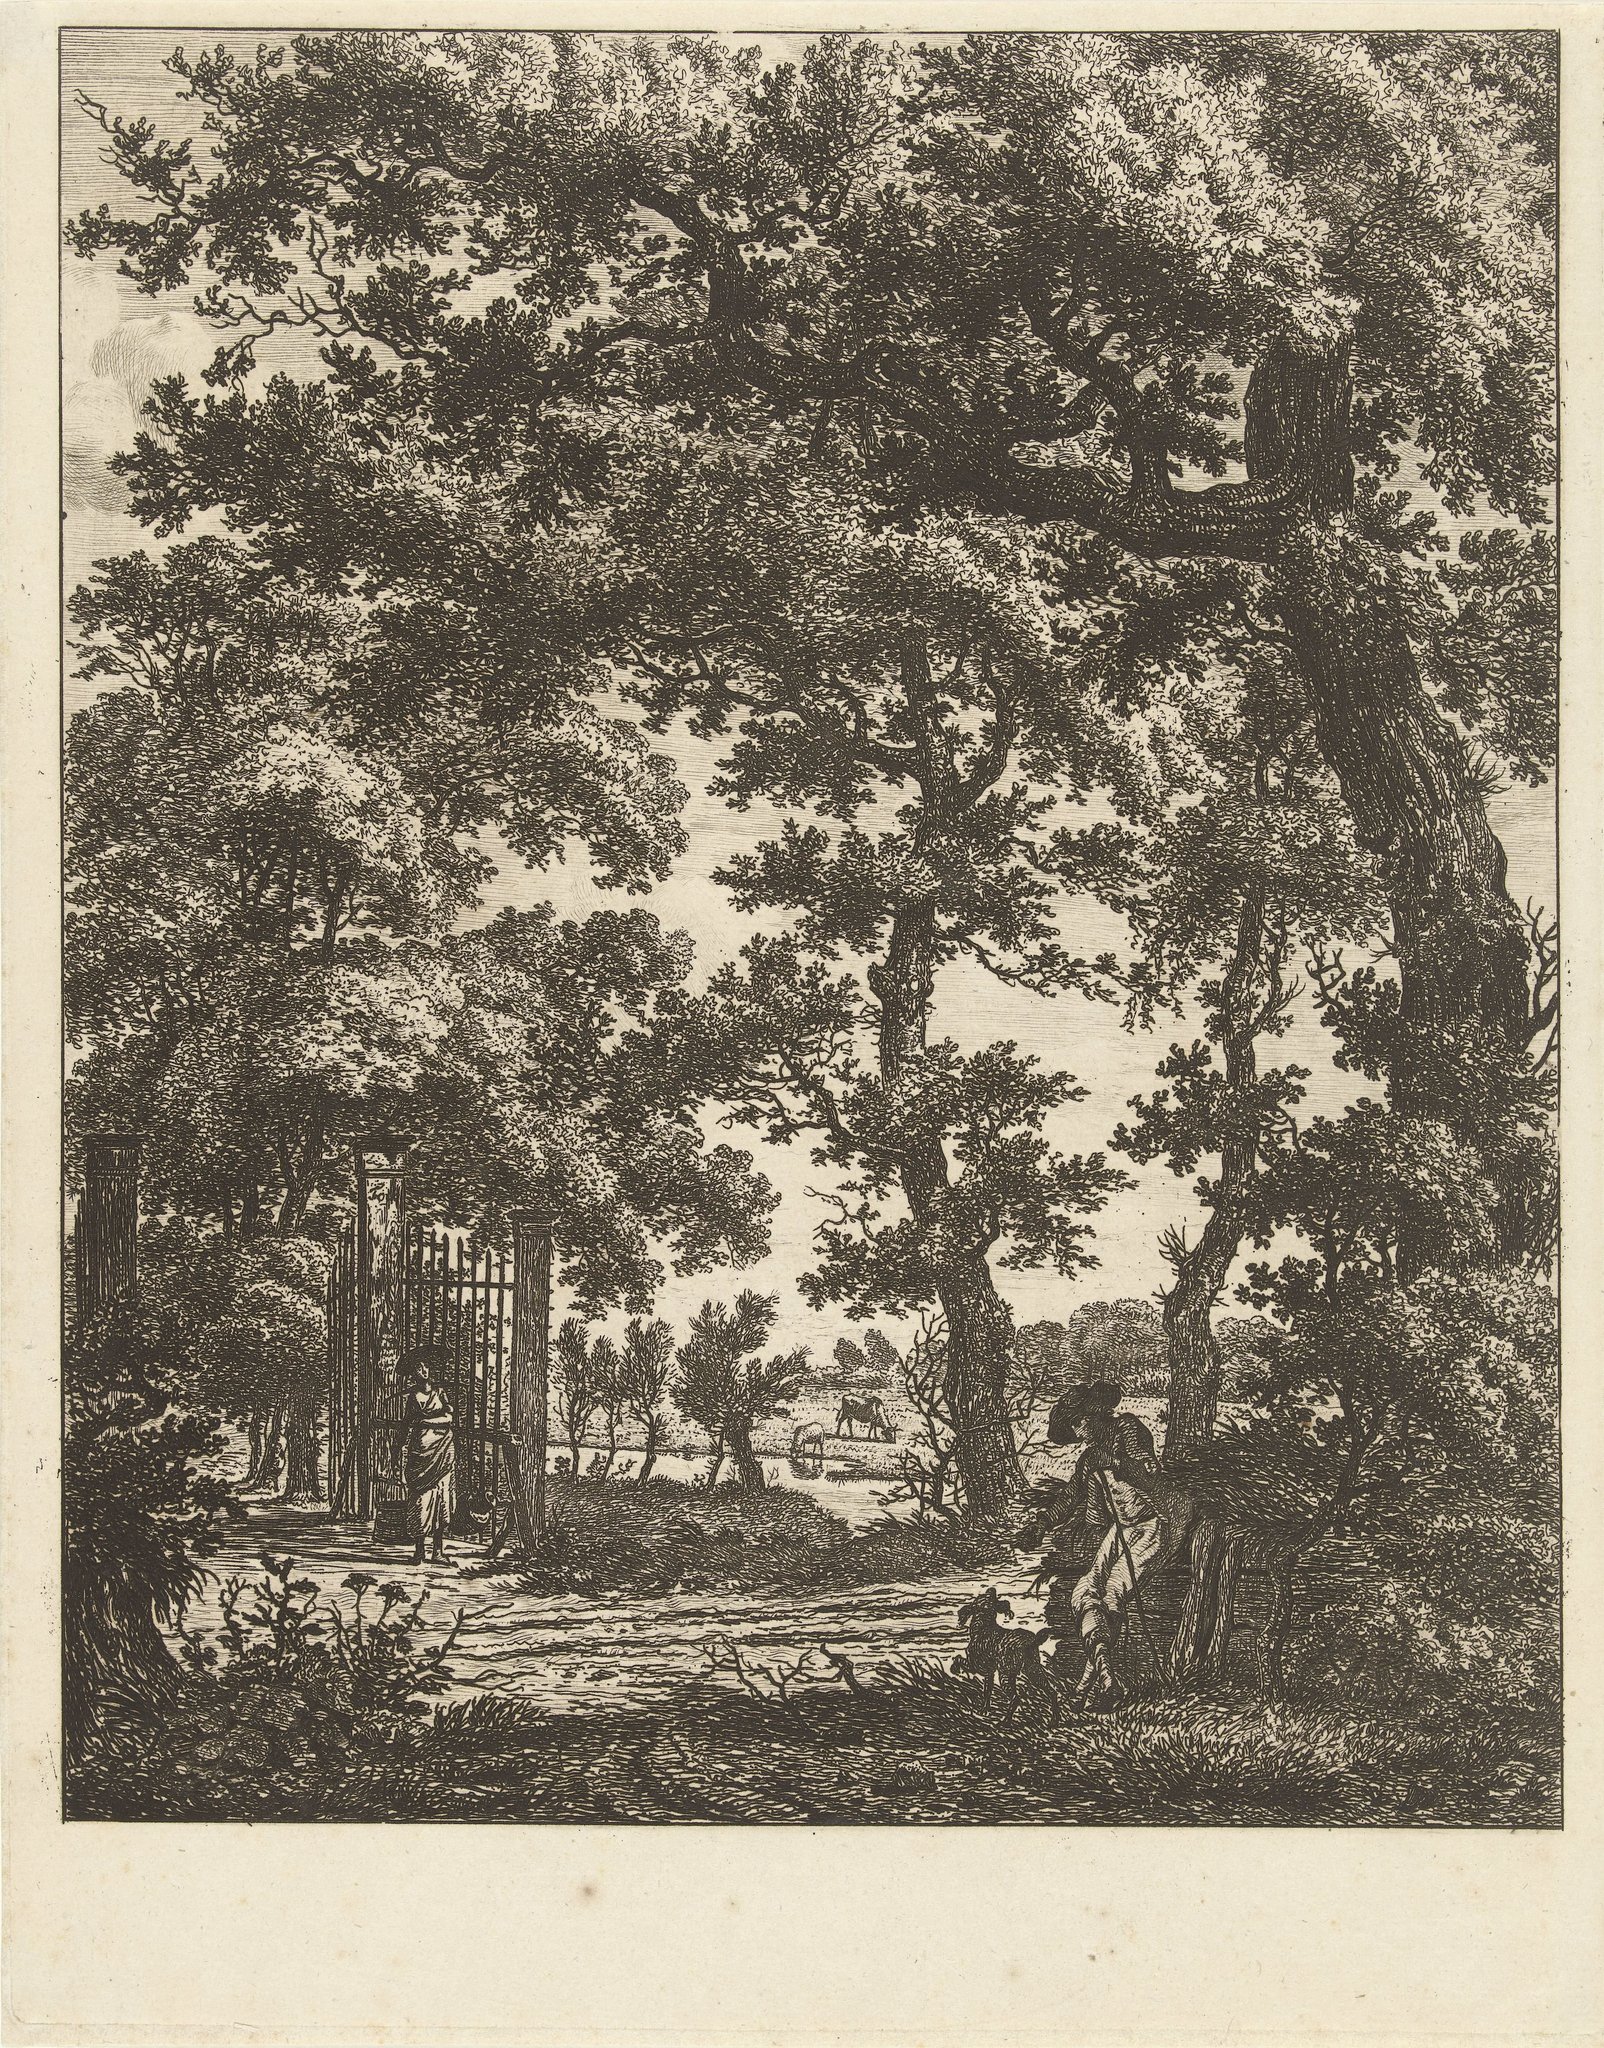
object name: print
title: Landschap met vrouw met juk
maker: hermanus fock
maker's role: conservator, draughtsman, painter, print maker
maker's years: 1766-1822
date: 1781-1822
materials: paper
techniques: etching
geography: amsterdam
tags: forest, wood, carrying something with yoke (+ one person ~ traffic and transport)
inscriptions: collector's mark: Lugt 2228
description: Naast een zandweg met hoge bomen, staat een man met een hond bij een schutting. Voor een geopend hek staat een vrouw met een melkjuk, waaraan een emmer en een kan hangen. Op de achtergrond een grazende koe en een drinkend schaap.